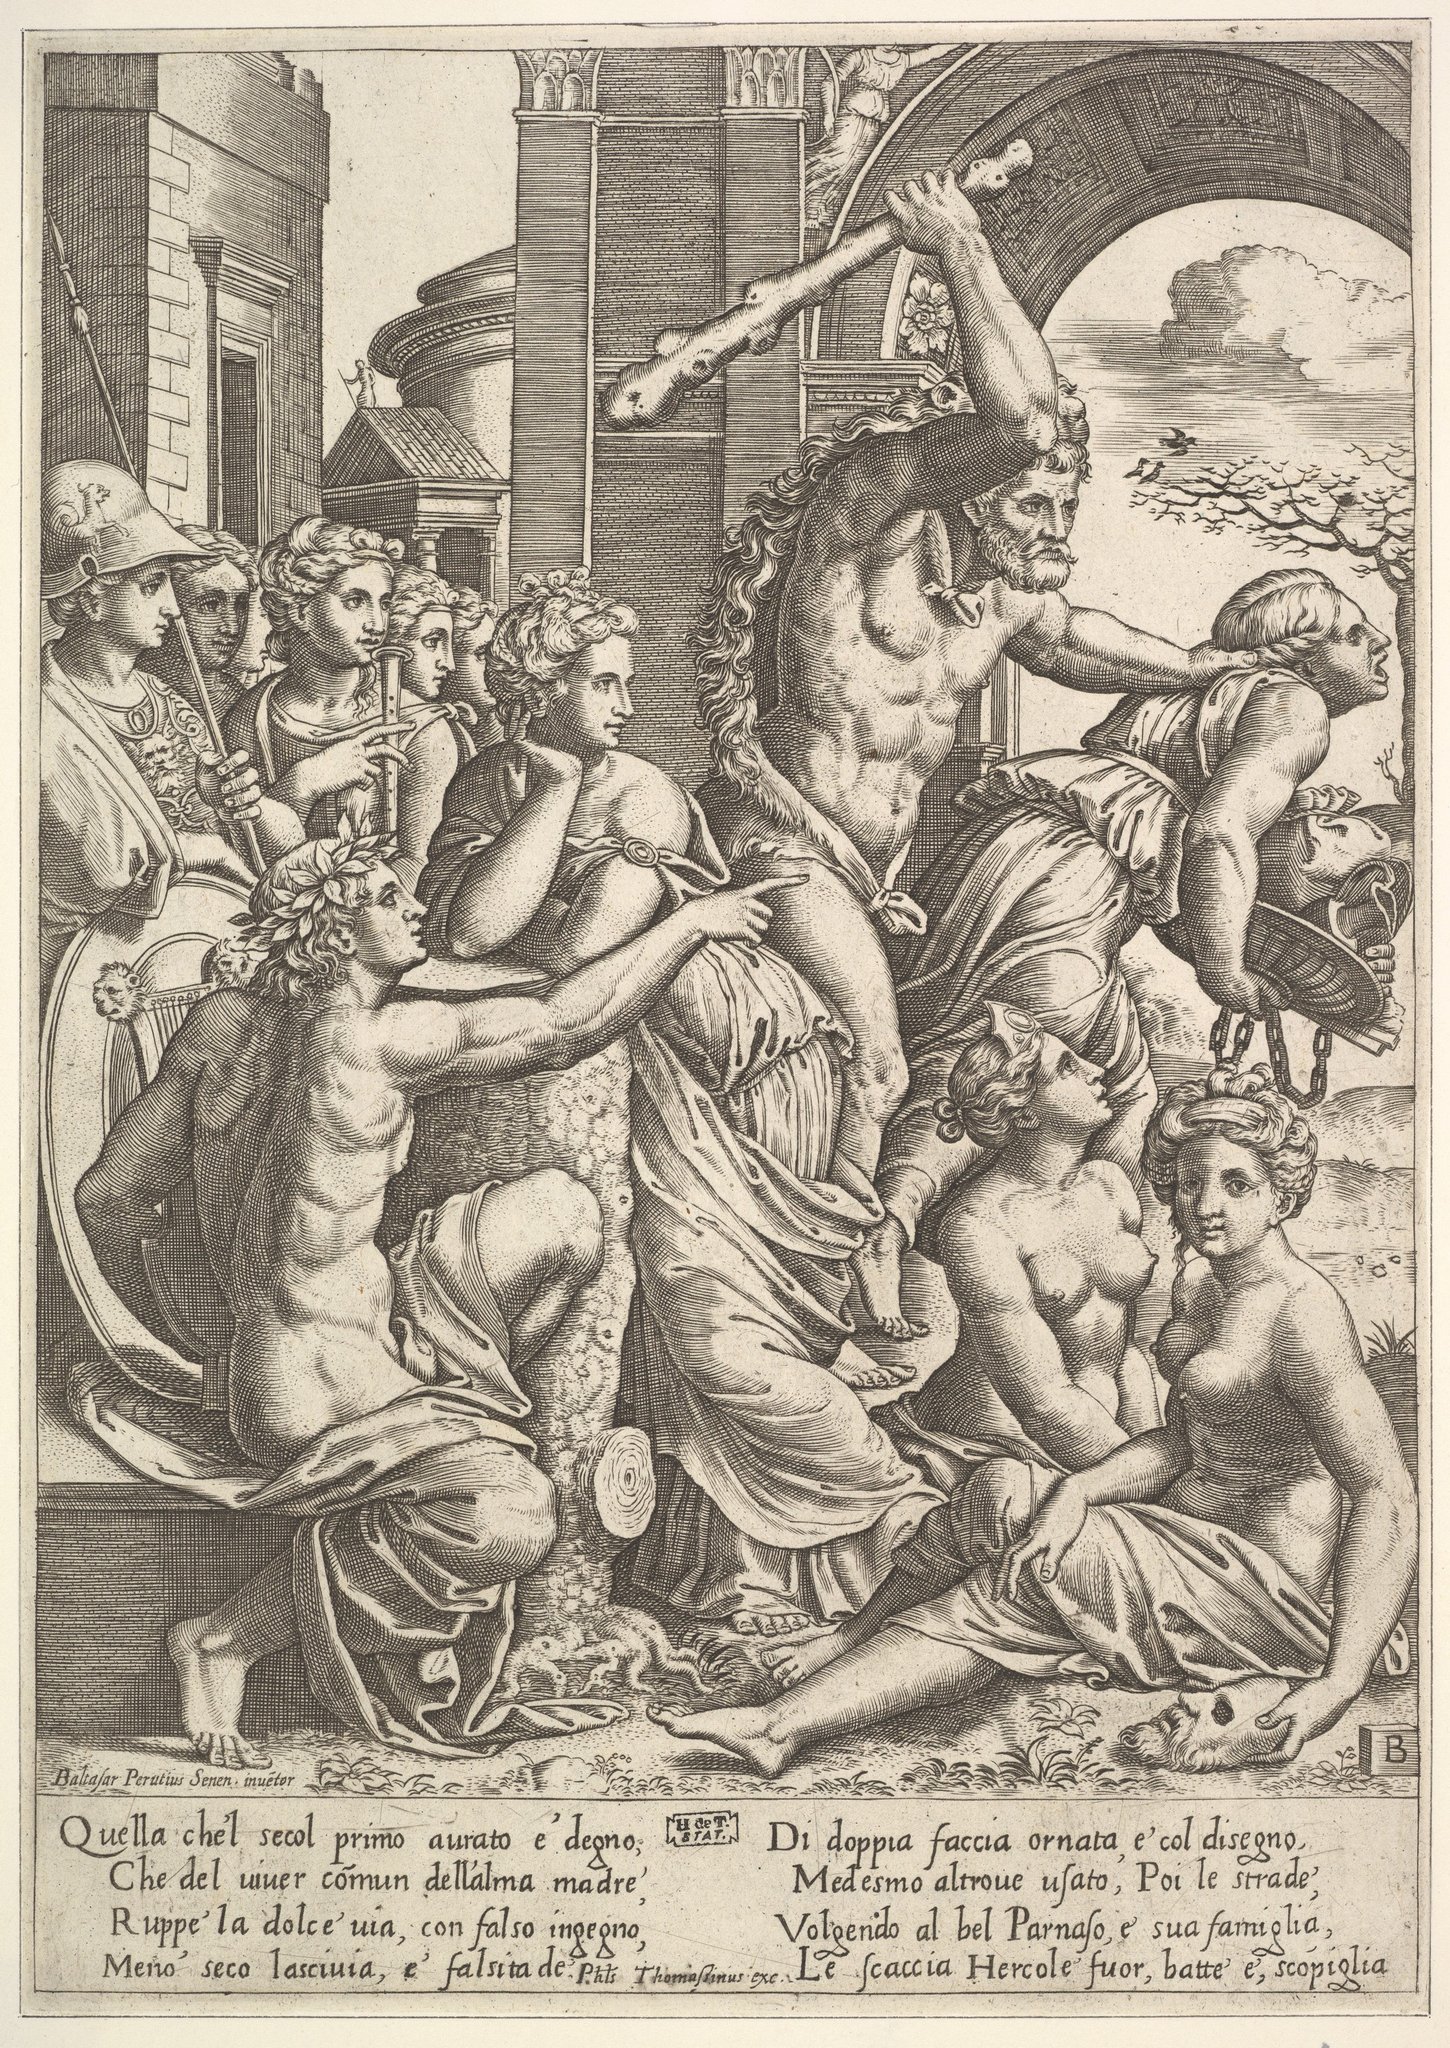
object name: print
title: Envy or Avarice at the right being driven from the temple of the Muses by Hercules who raises a club, the muses watching from the left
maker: master of the die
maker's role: artist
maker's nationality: italian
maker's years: 1525-1560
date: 1530-1560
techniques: engraving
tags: weapons,female nudes,hercules,muses